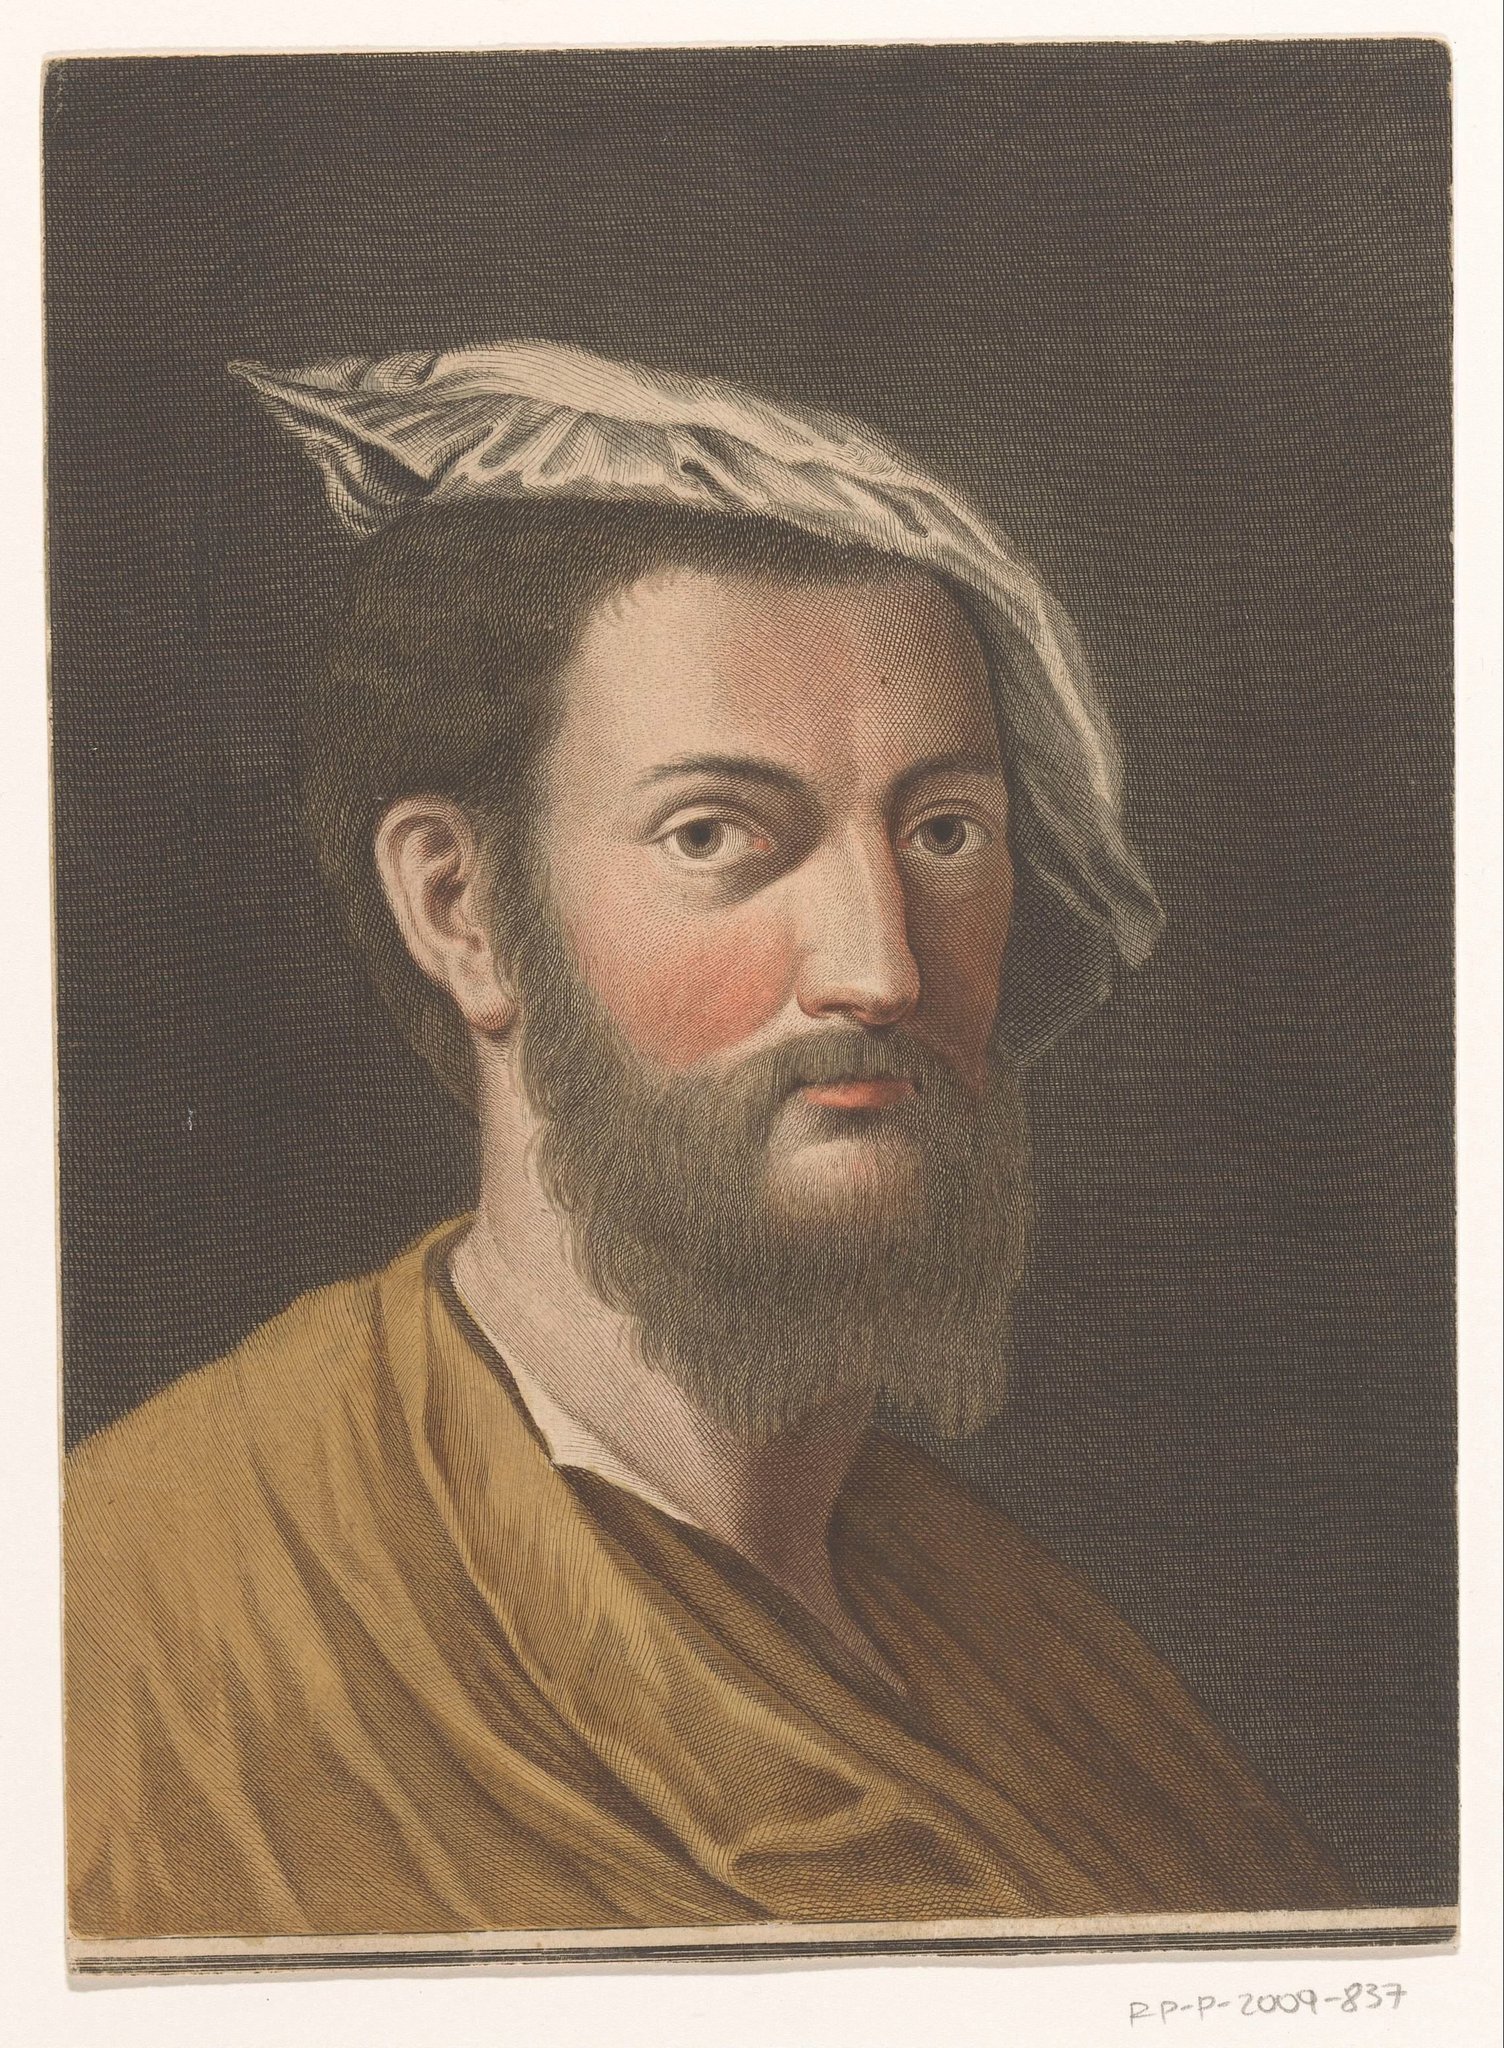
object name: book illustration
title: Portret van kunstenaar Francesco Primaticcio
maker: antonio pazzi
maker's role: painter, print maker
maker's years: 1706-1768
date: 1752-1762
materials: paper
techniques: printing, colour, engraving, lithography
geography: italy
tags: paris, painter, draughtsman, sculptor, francesco primaticcio, historical persons, portrait, self-portrait of artist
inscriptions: collector's mark: Lugt 2760, collector's mark: Lugt 2228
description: Prent naar geschilderd zelfportret van Francesco Primaticcio in de Galleria degli Uffizi te Florence (inv.nr. 1771). Prent uit: Moücke, Francesco. Serie di ritratti degli eccellenti pittori dipinti di propria mano, che esistono nell'Imiperial Galleria di Firenze. Florence: 1752-1762, dl. I.